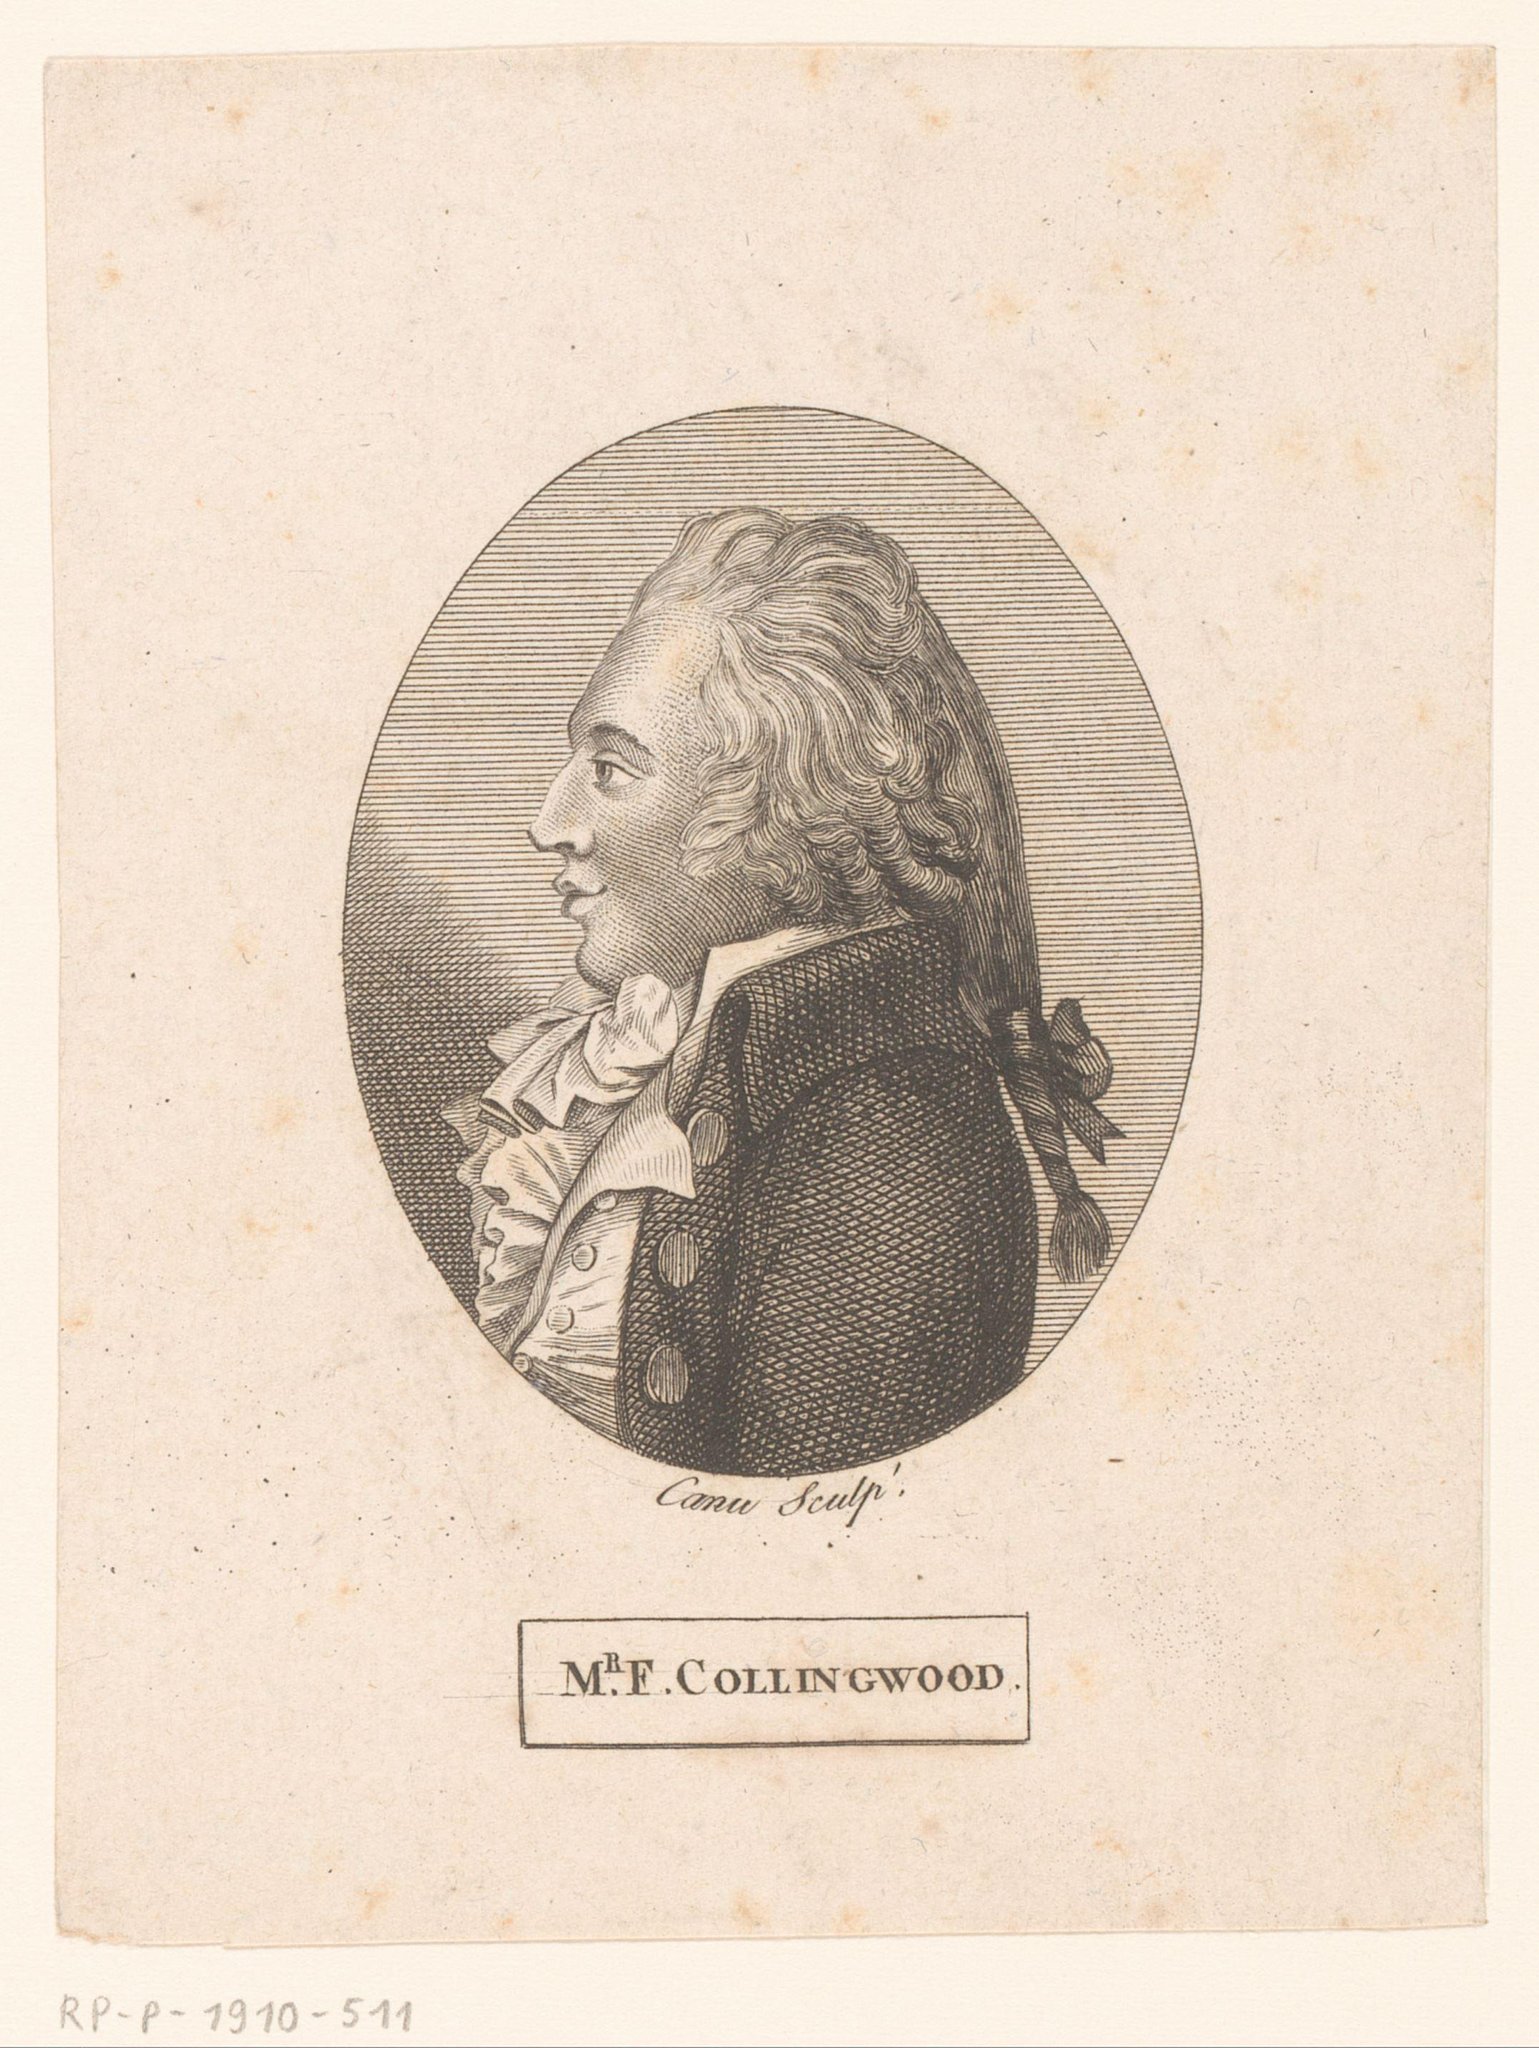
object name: print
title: Mr. F. Collingwood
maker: jean dominique etienne canu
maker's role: print maker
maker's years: 1768-1843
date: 1778-1843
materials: paper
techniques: engraving, etching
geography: france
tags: ornament ~ medallion, historical persons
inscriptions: collector's mark: Lugt 2228